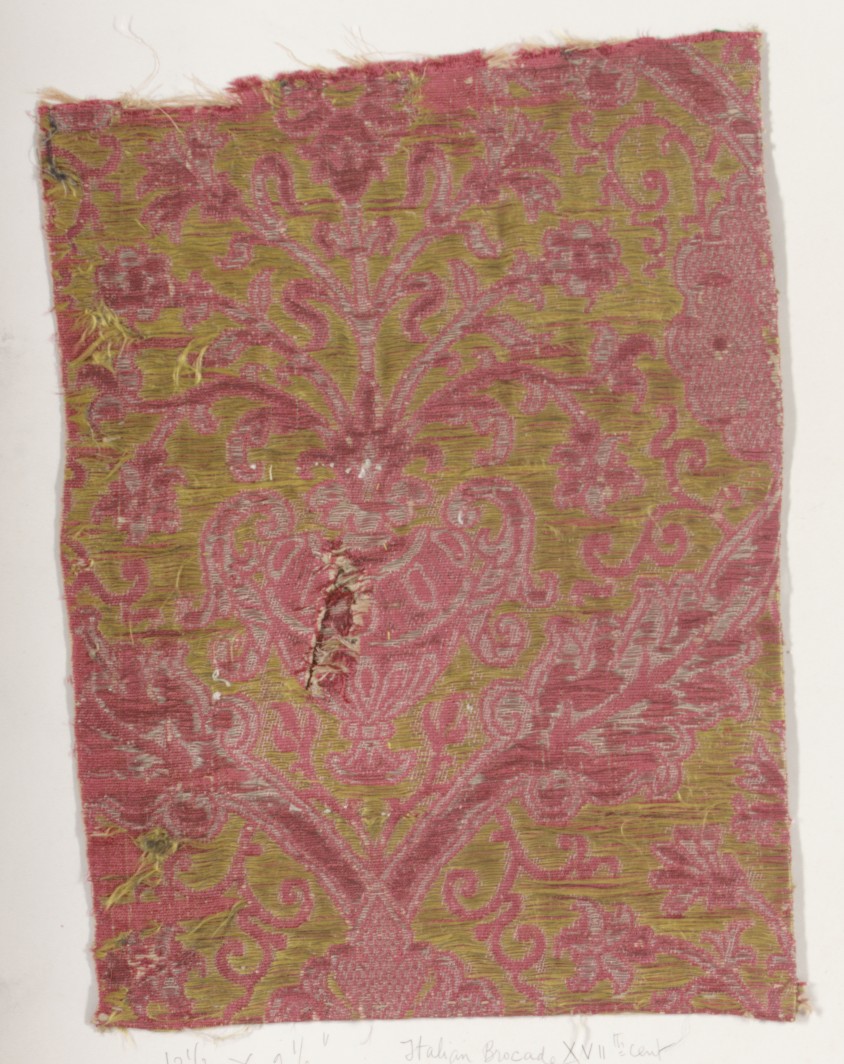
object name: fragment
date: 1601-1700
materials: metal thread, silk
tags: flowers